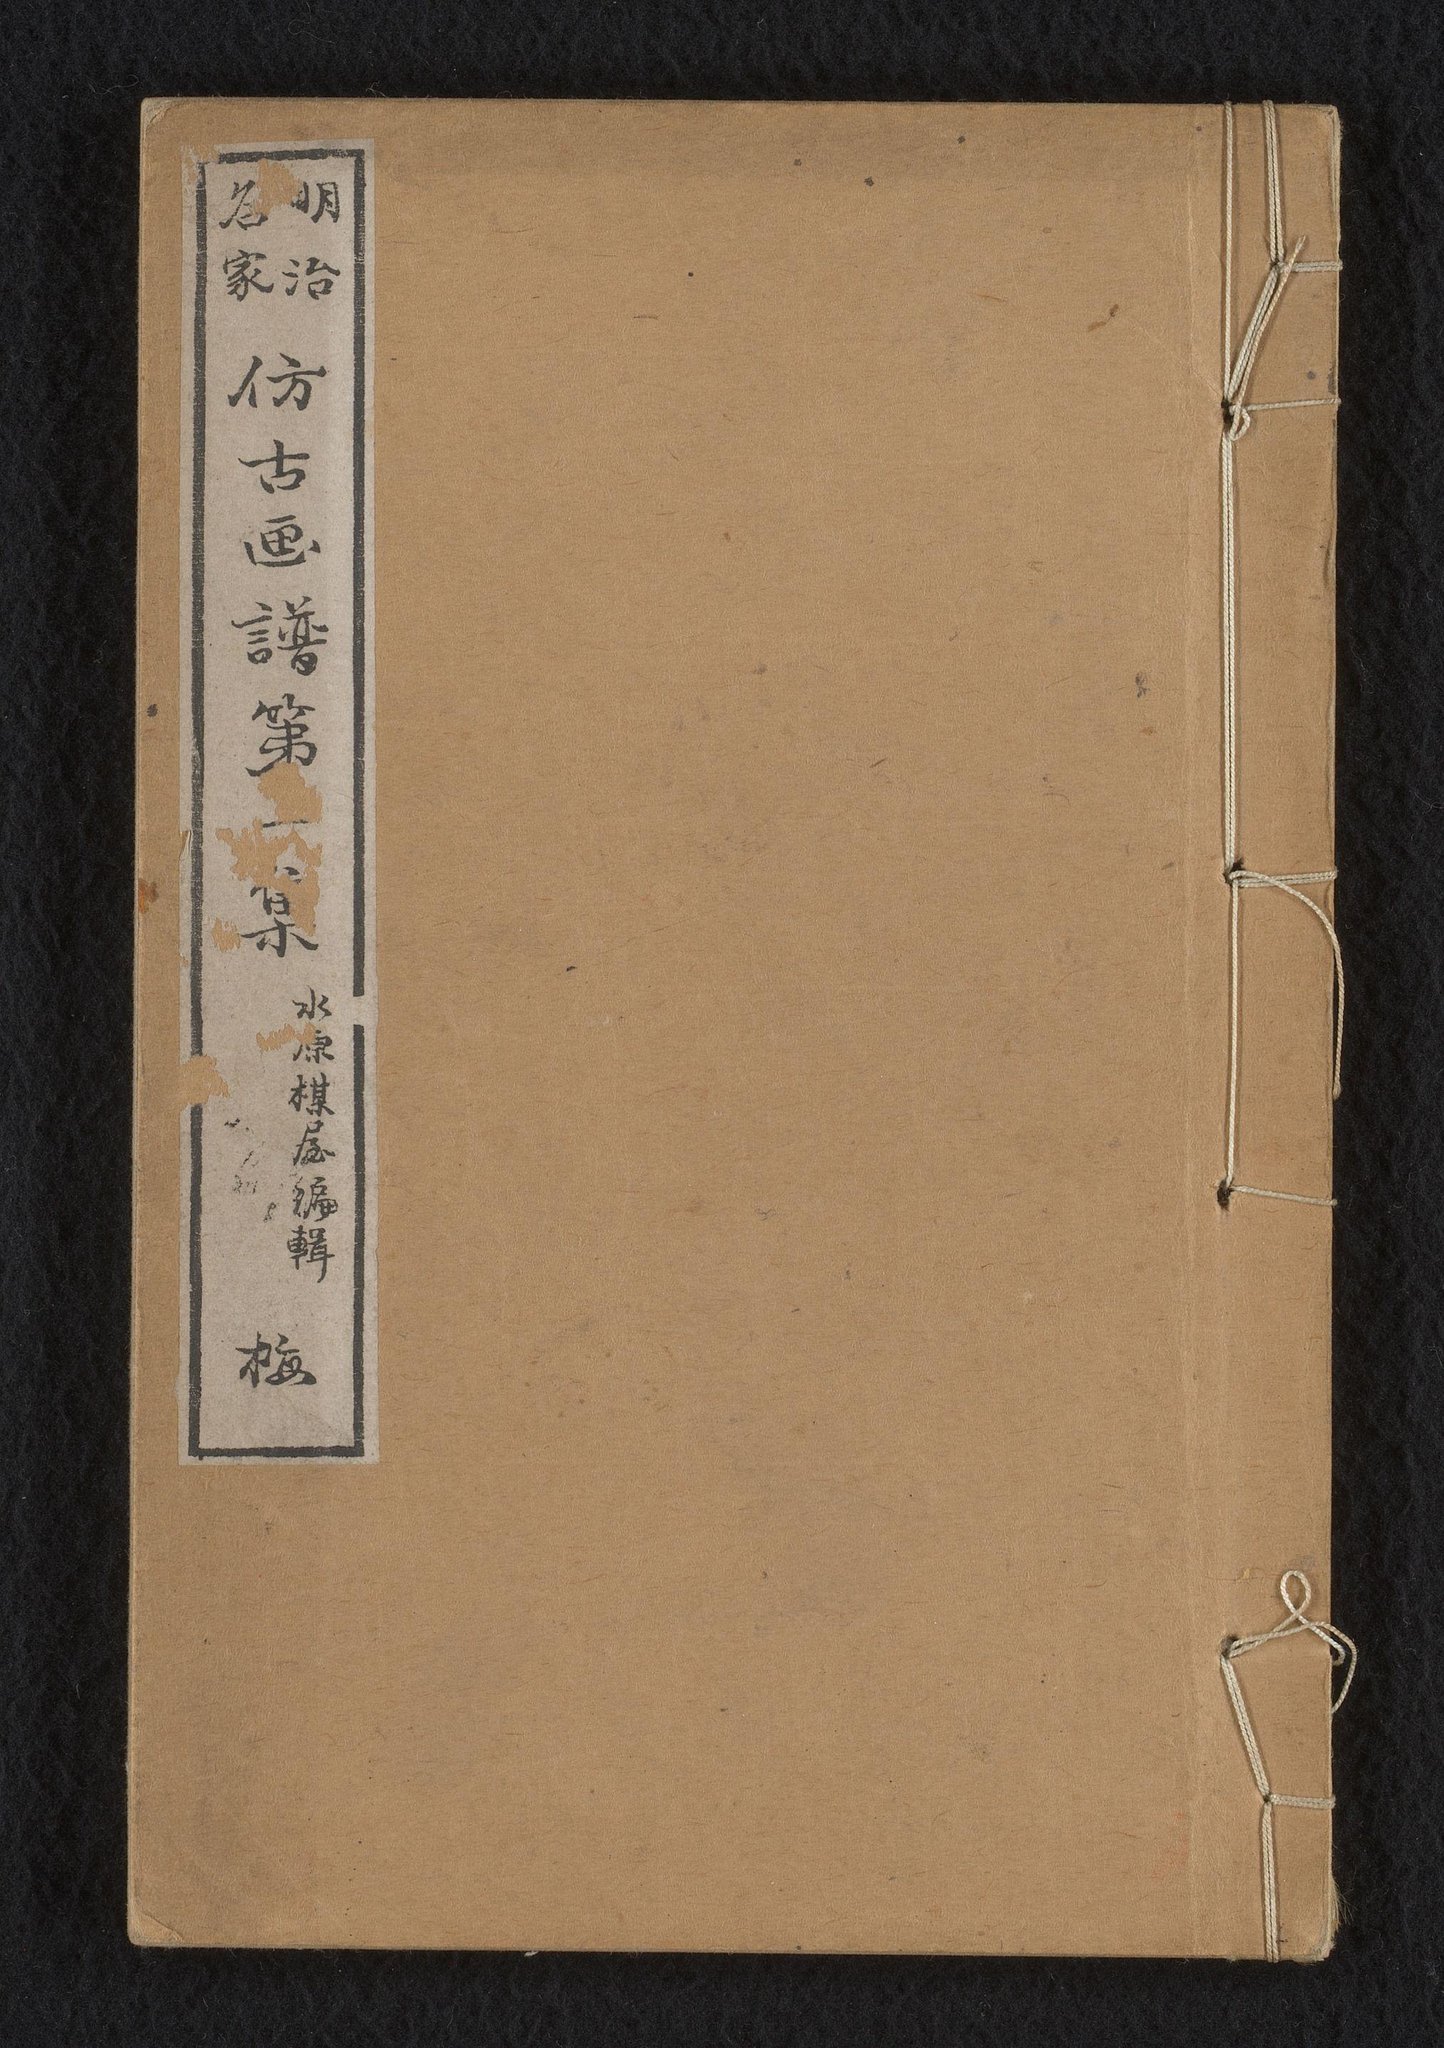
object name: book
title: Baifu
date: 1880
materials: paper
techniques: woodcut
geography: osaka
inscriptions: date